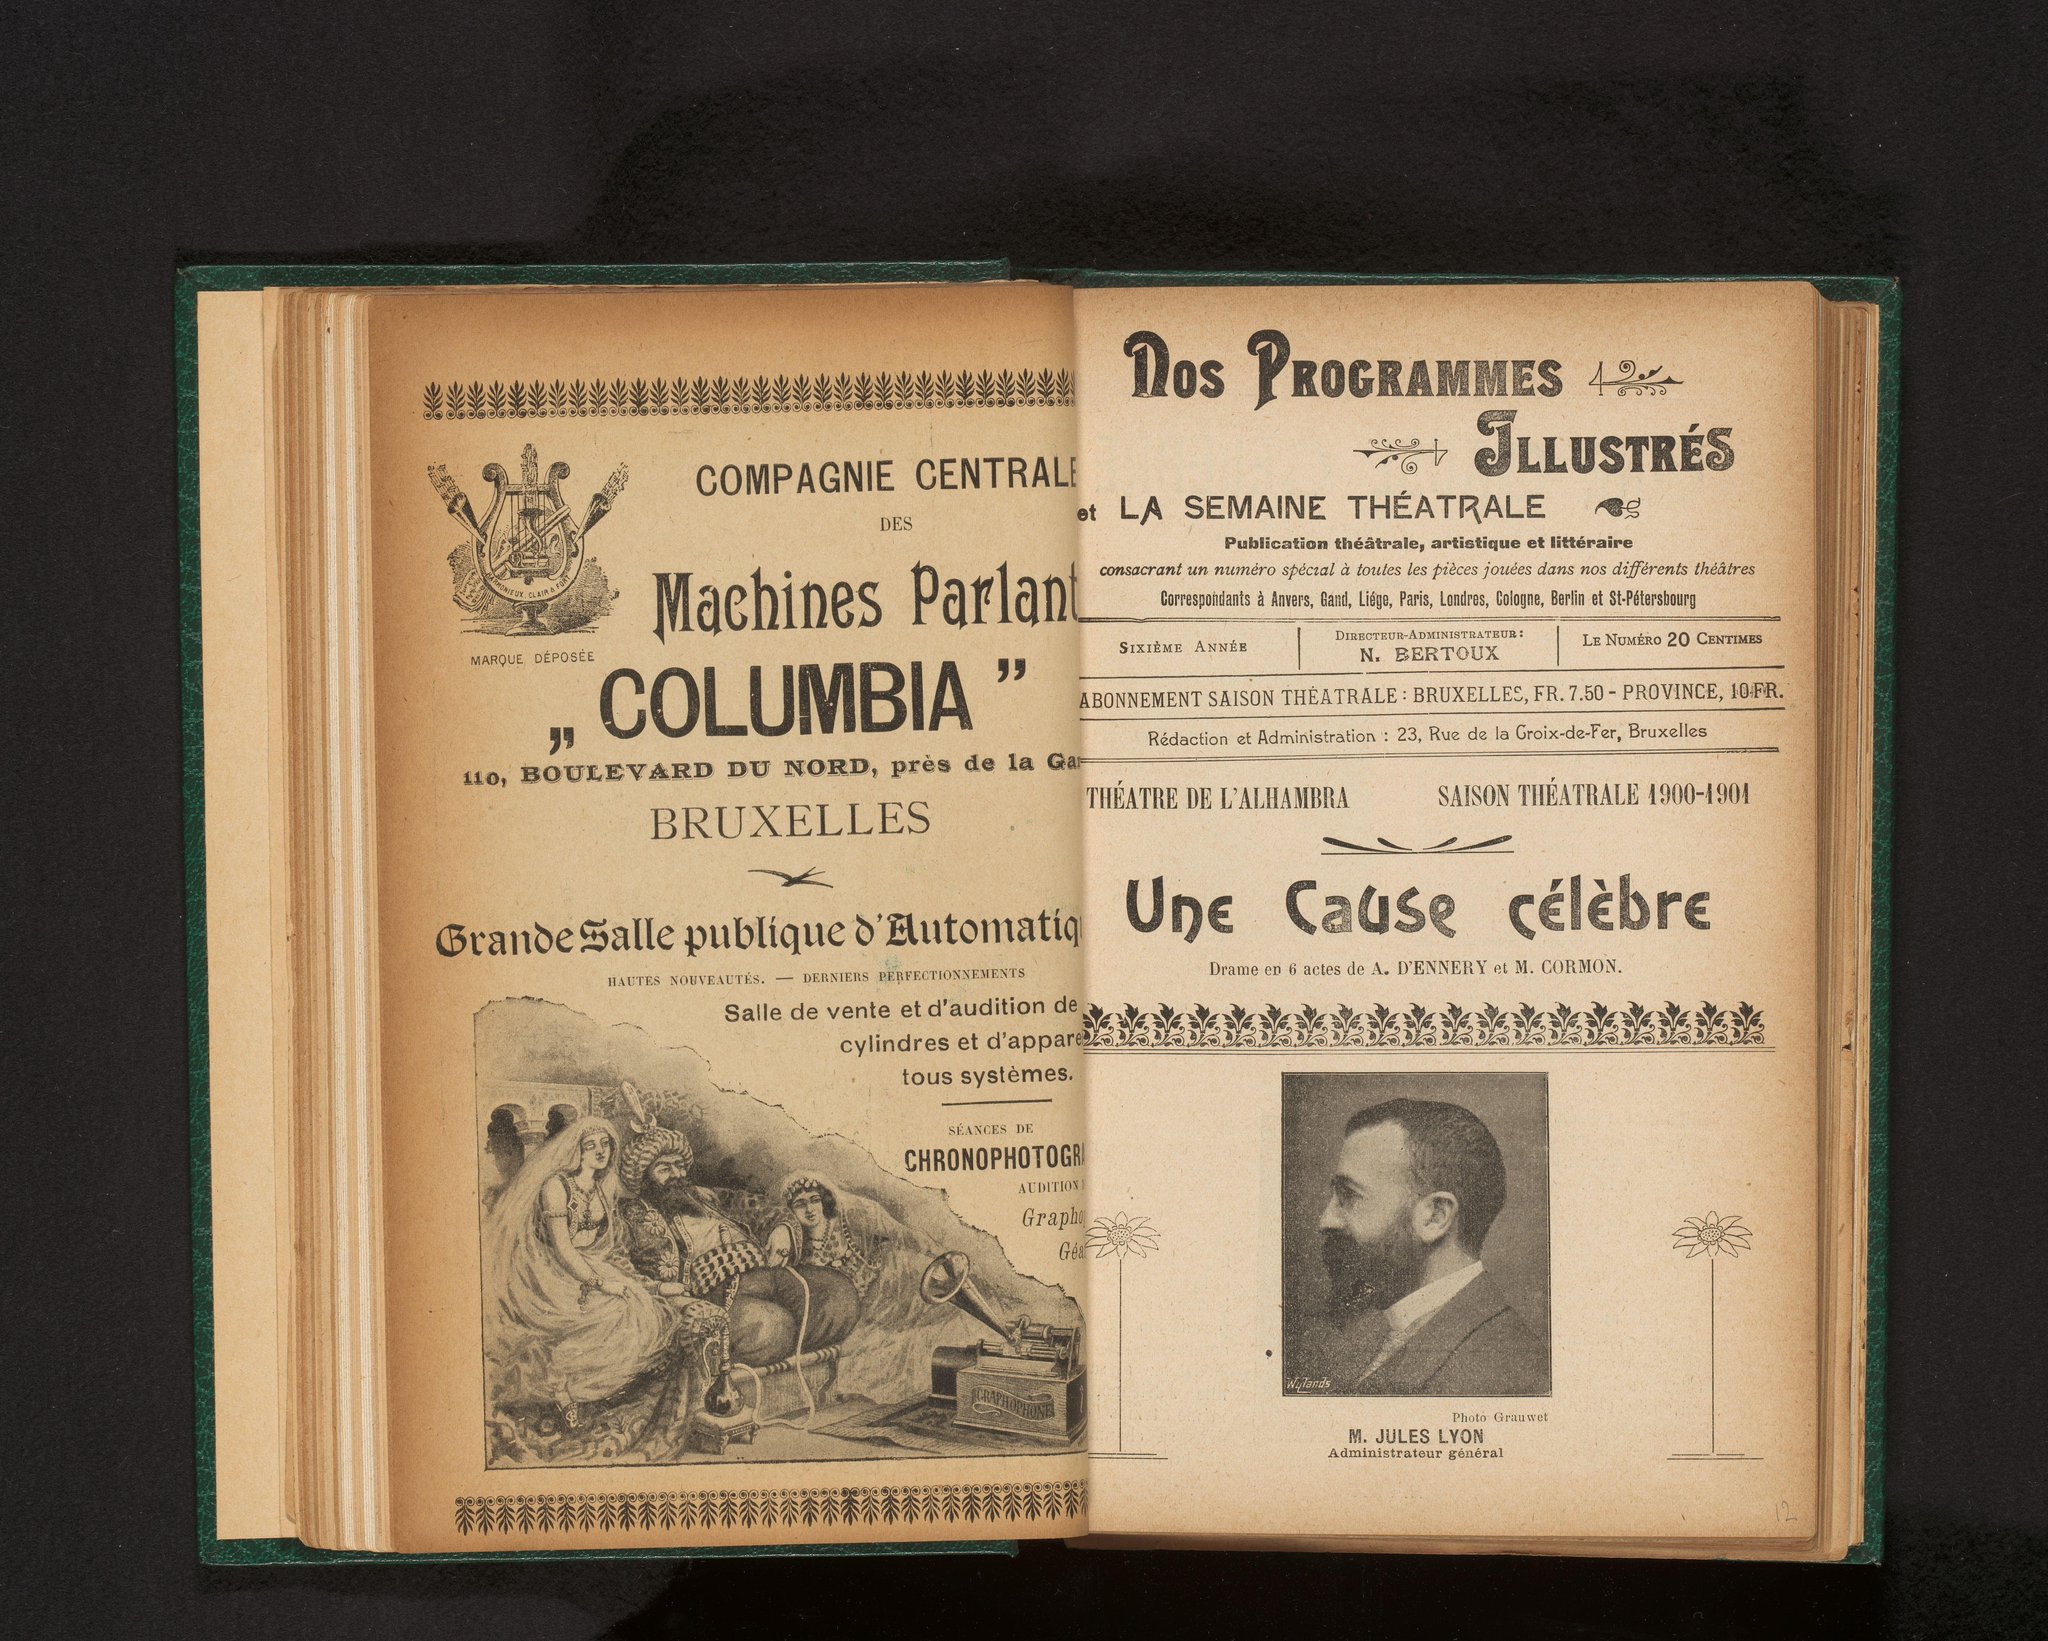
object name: photomechanical print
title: M Jules Lyon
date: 1895-1900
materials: paper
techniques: autotype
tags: adult man, historical persons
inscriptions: inscription: ‘Administrateur general’